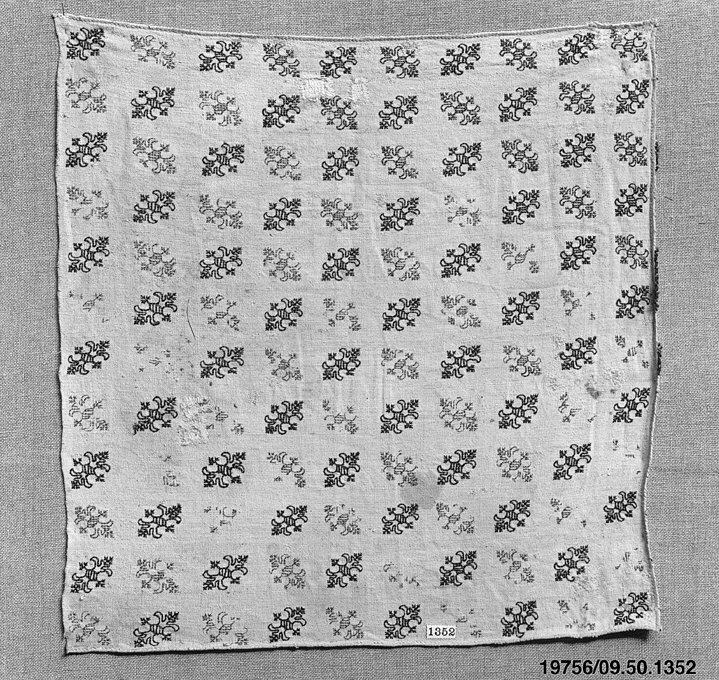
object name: fragment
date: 1701-1800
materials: linen